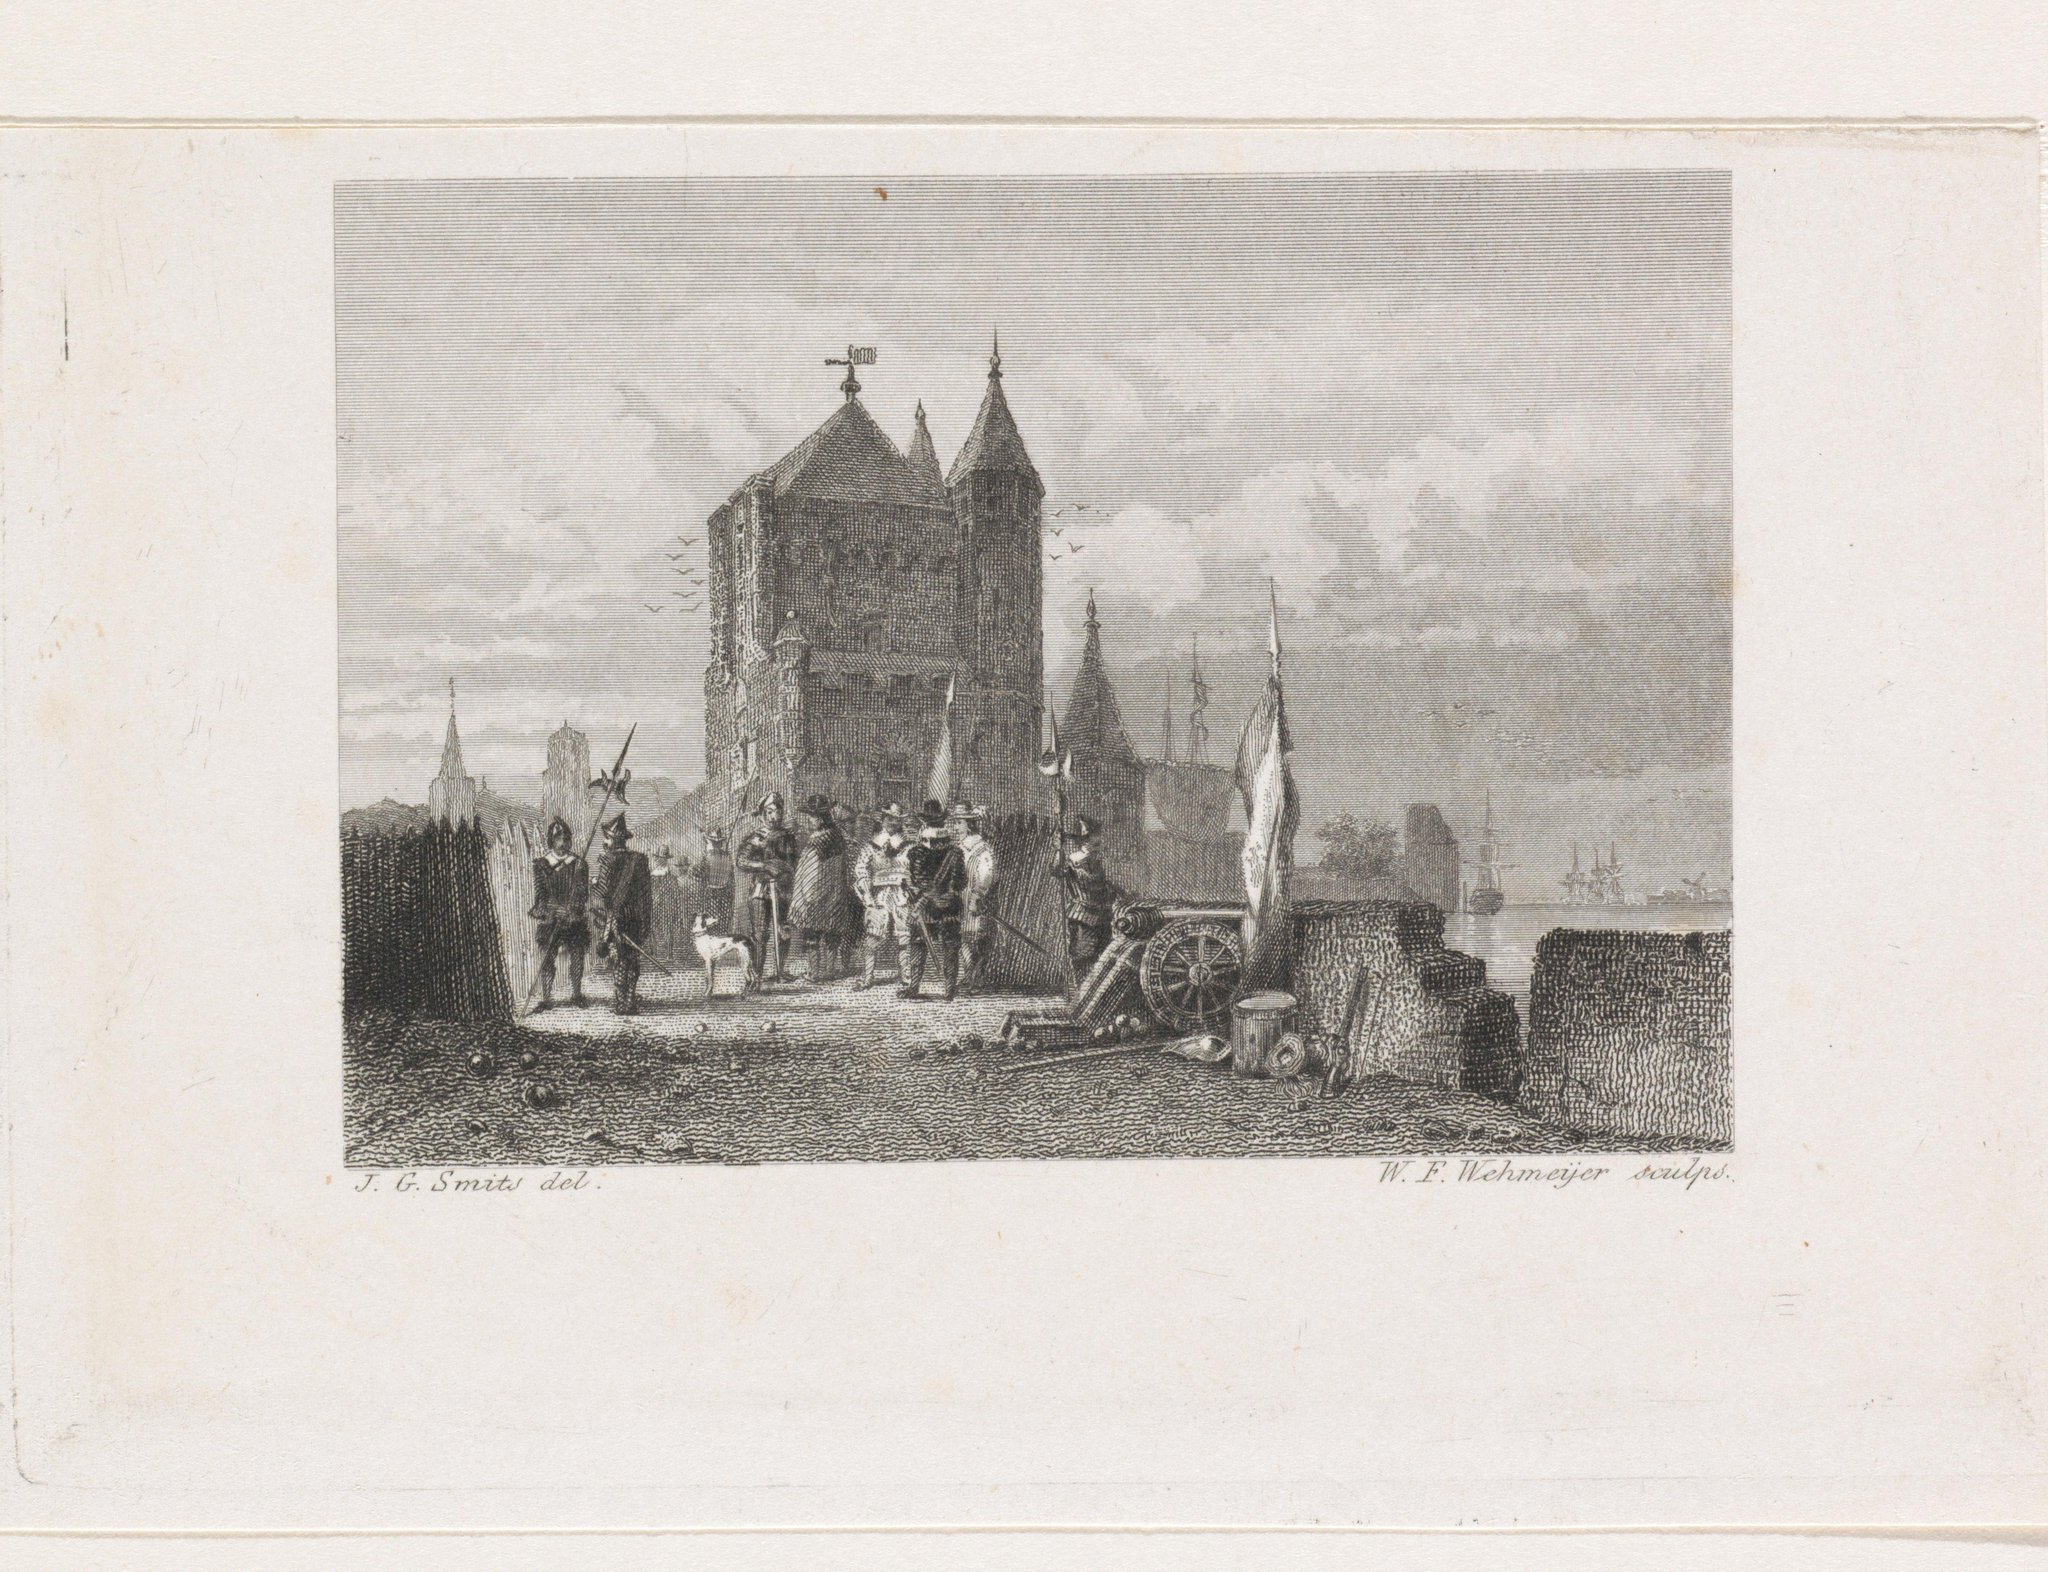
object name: print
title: Soldaten bij verdedigingswerken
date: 1838-1854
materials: paper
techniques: engraving, etching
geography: the hague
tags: city-view, and landscape with man-made constructions, towers ~ fortified city, landscapes with waters, waterscapes, seascapes (in the temperate zone), church (exterior), walls ~ fortified city, the soldier; the soldier's life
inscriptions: collector's mark: Lugt 2228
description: Bewapende soldaten staan bij een kanon. Achter hen is een gedeelte van de verdedigingswerken te zien met enkele torens. In de verte is een kerk weergegeven. De vesting ligt aan het water.